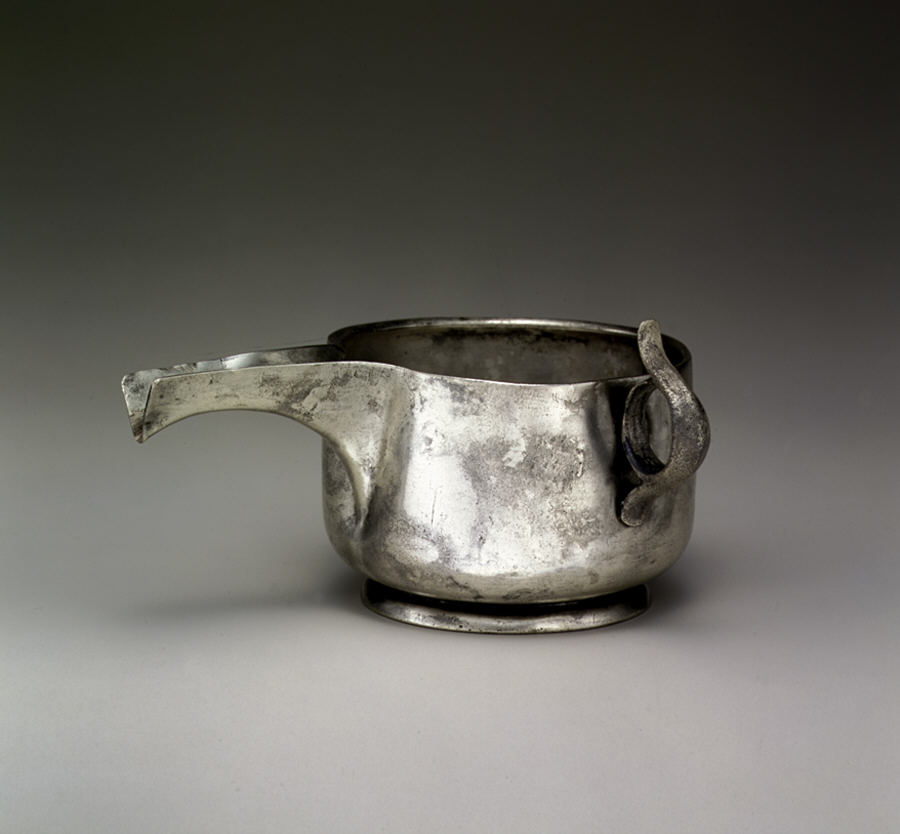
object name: pitcher with spout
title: Silver spouted pitcher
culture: roman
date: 67-35 BCE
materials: silver